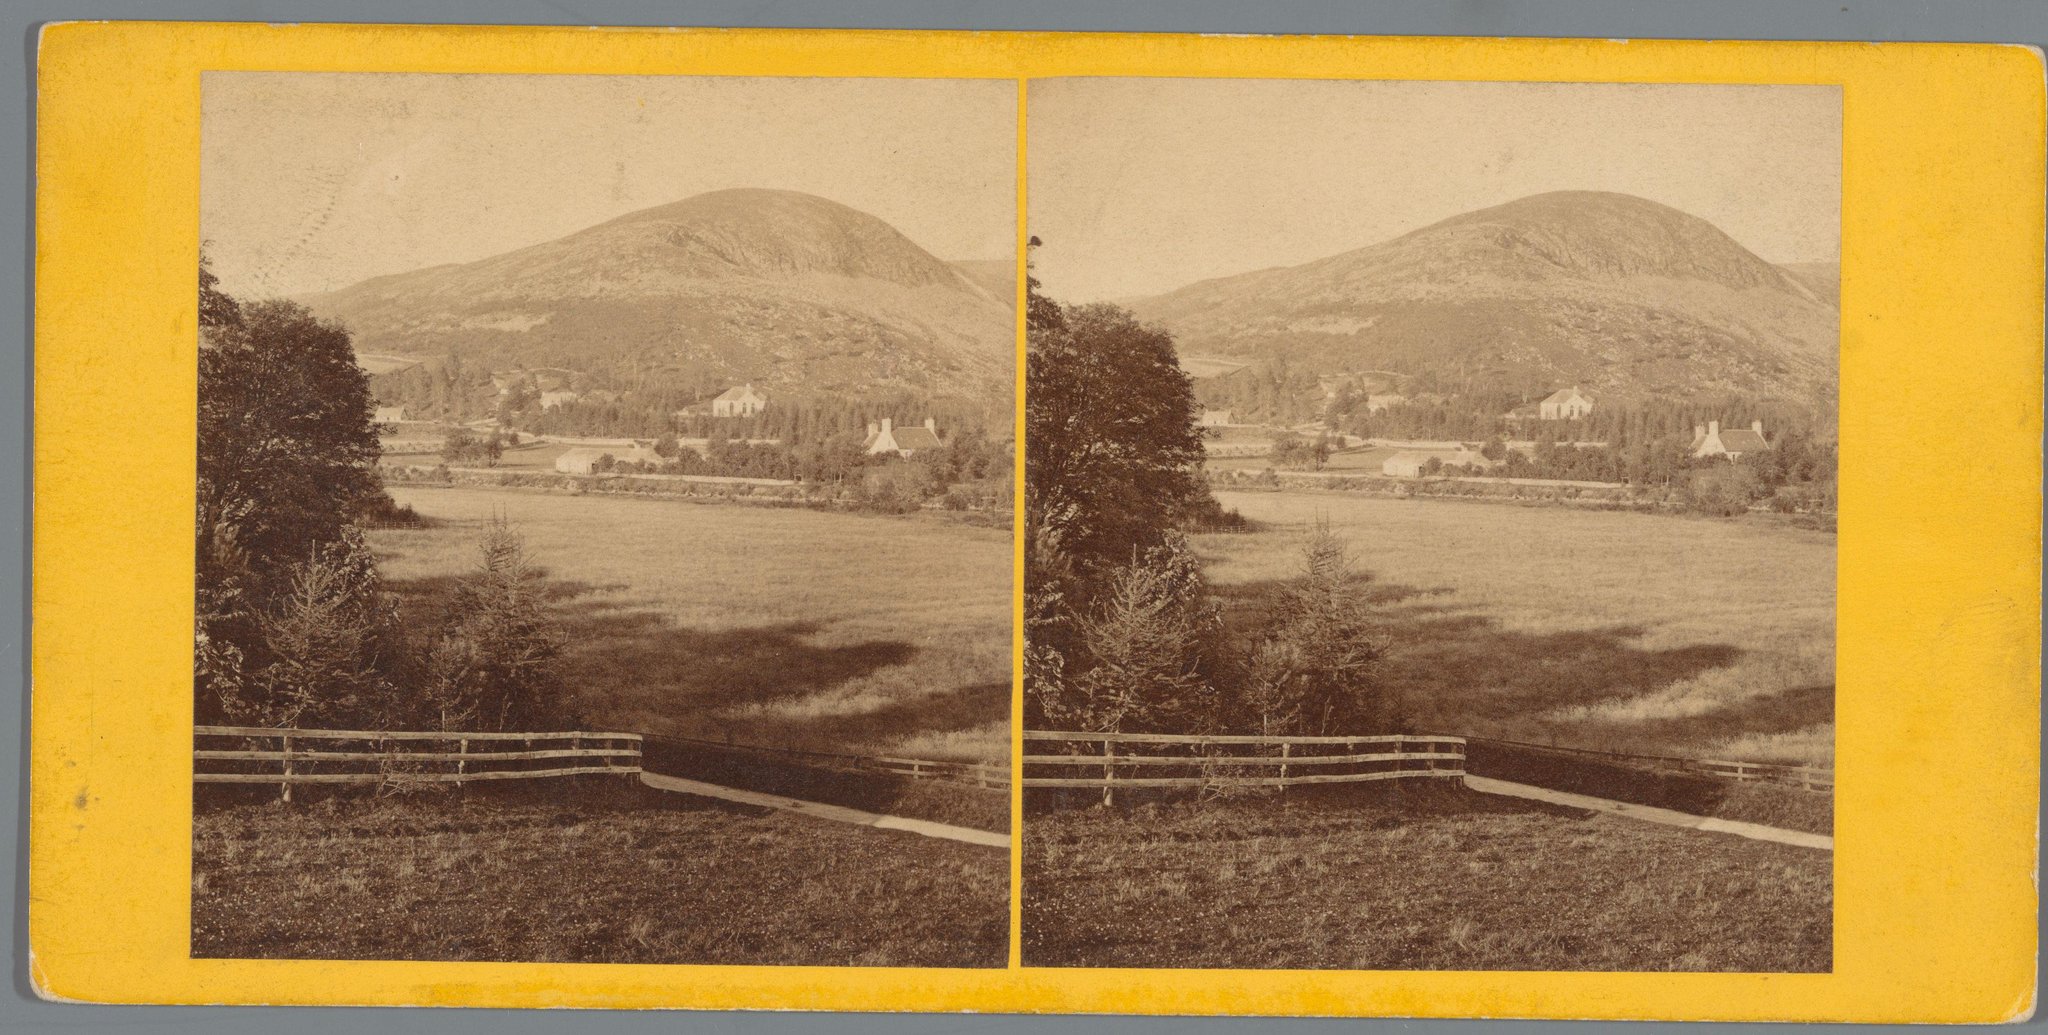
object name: stereograph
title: The Church of Crathie, Balmoral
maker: george washington wilson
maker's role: publisher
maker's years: 1823-1893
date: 1860-1865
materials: cardboard, photographic support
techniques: albumen print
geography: aberdeen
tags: schotland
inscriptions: label: ‘G.W. Wilson & Co, Aberdeen No. 61 The Church of Crathie, Balmoral’